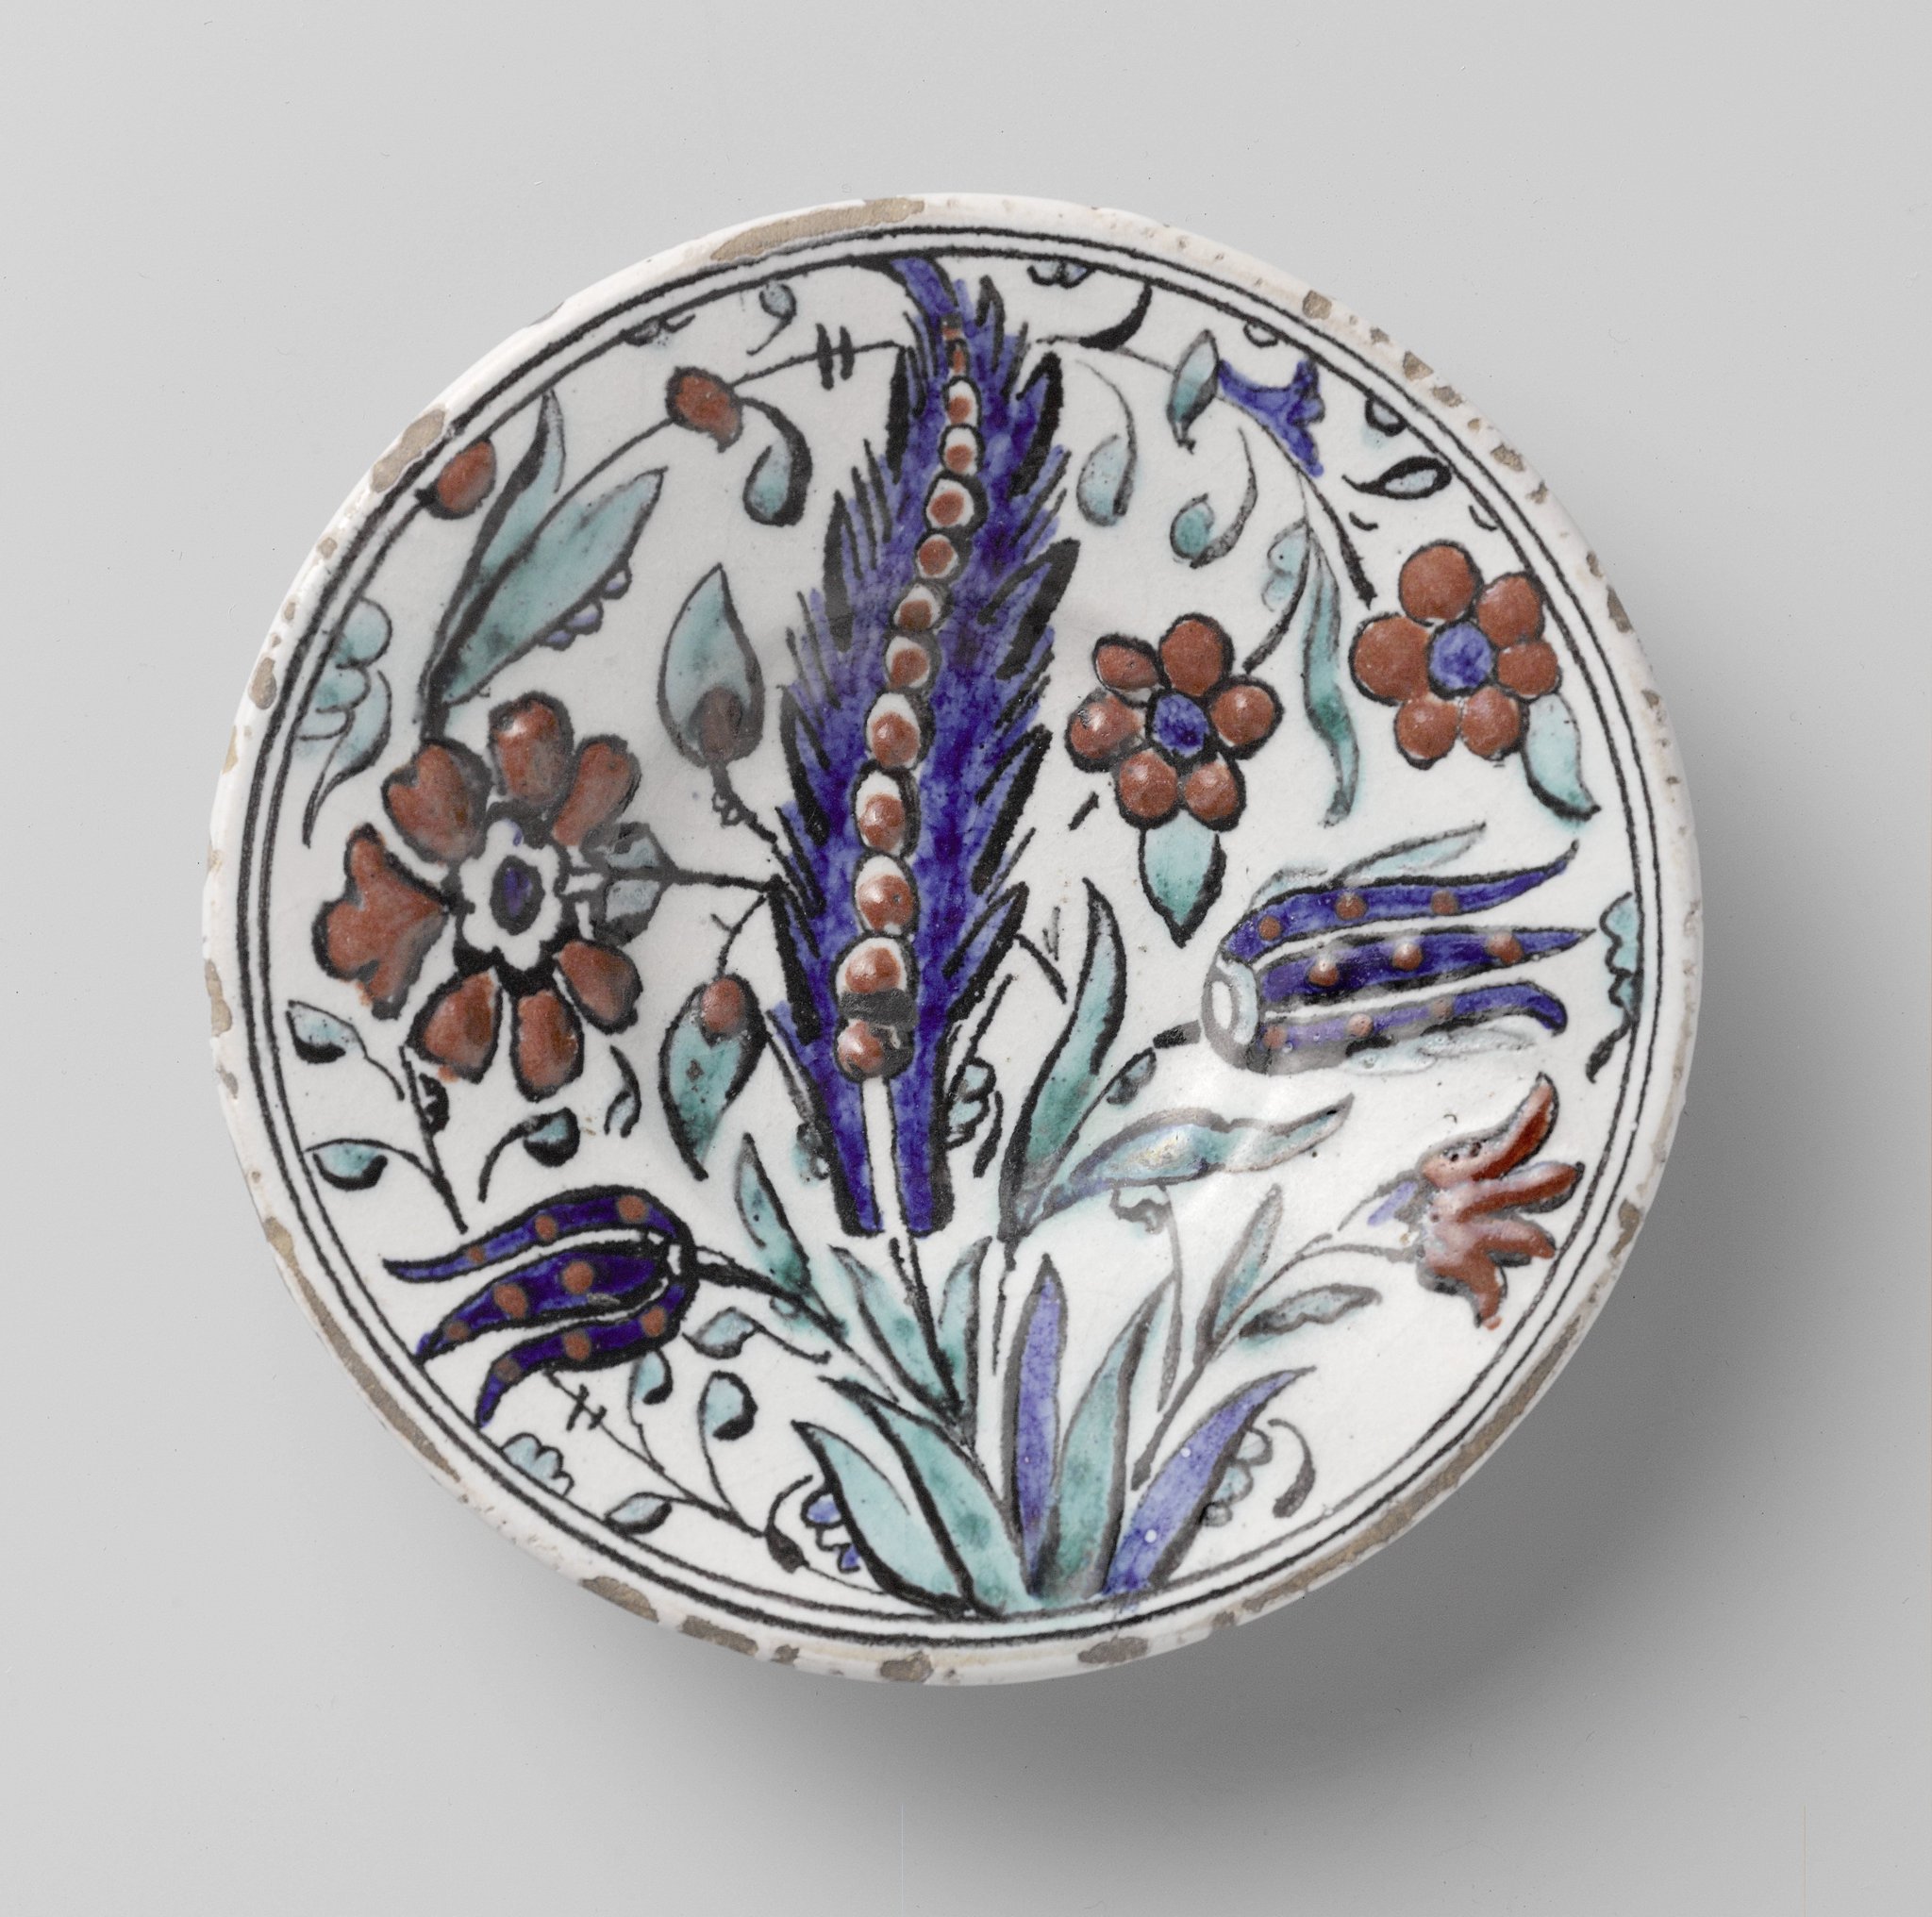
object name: plate dish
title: Plate with a stylized flowering plant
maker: Anonymous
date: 1540-1560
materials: cobalt, earthenware, glaze, paint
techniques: firing, turning, vitrification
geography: italy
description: Bord van aardewerk, beschilderd in onderglazuur blauw, rood, groen en zwart. Op de voorzijde een gestileerde bloeiende plant. Iznik-stijl.